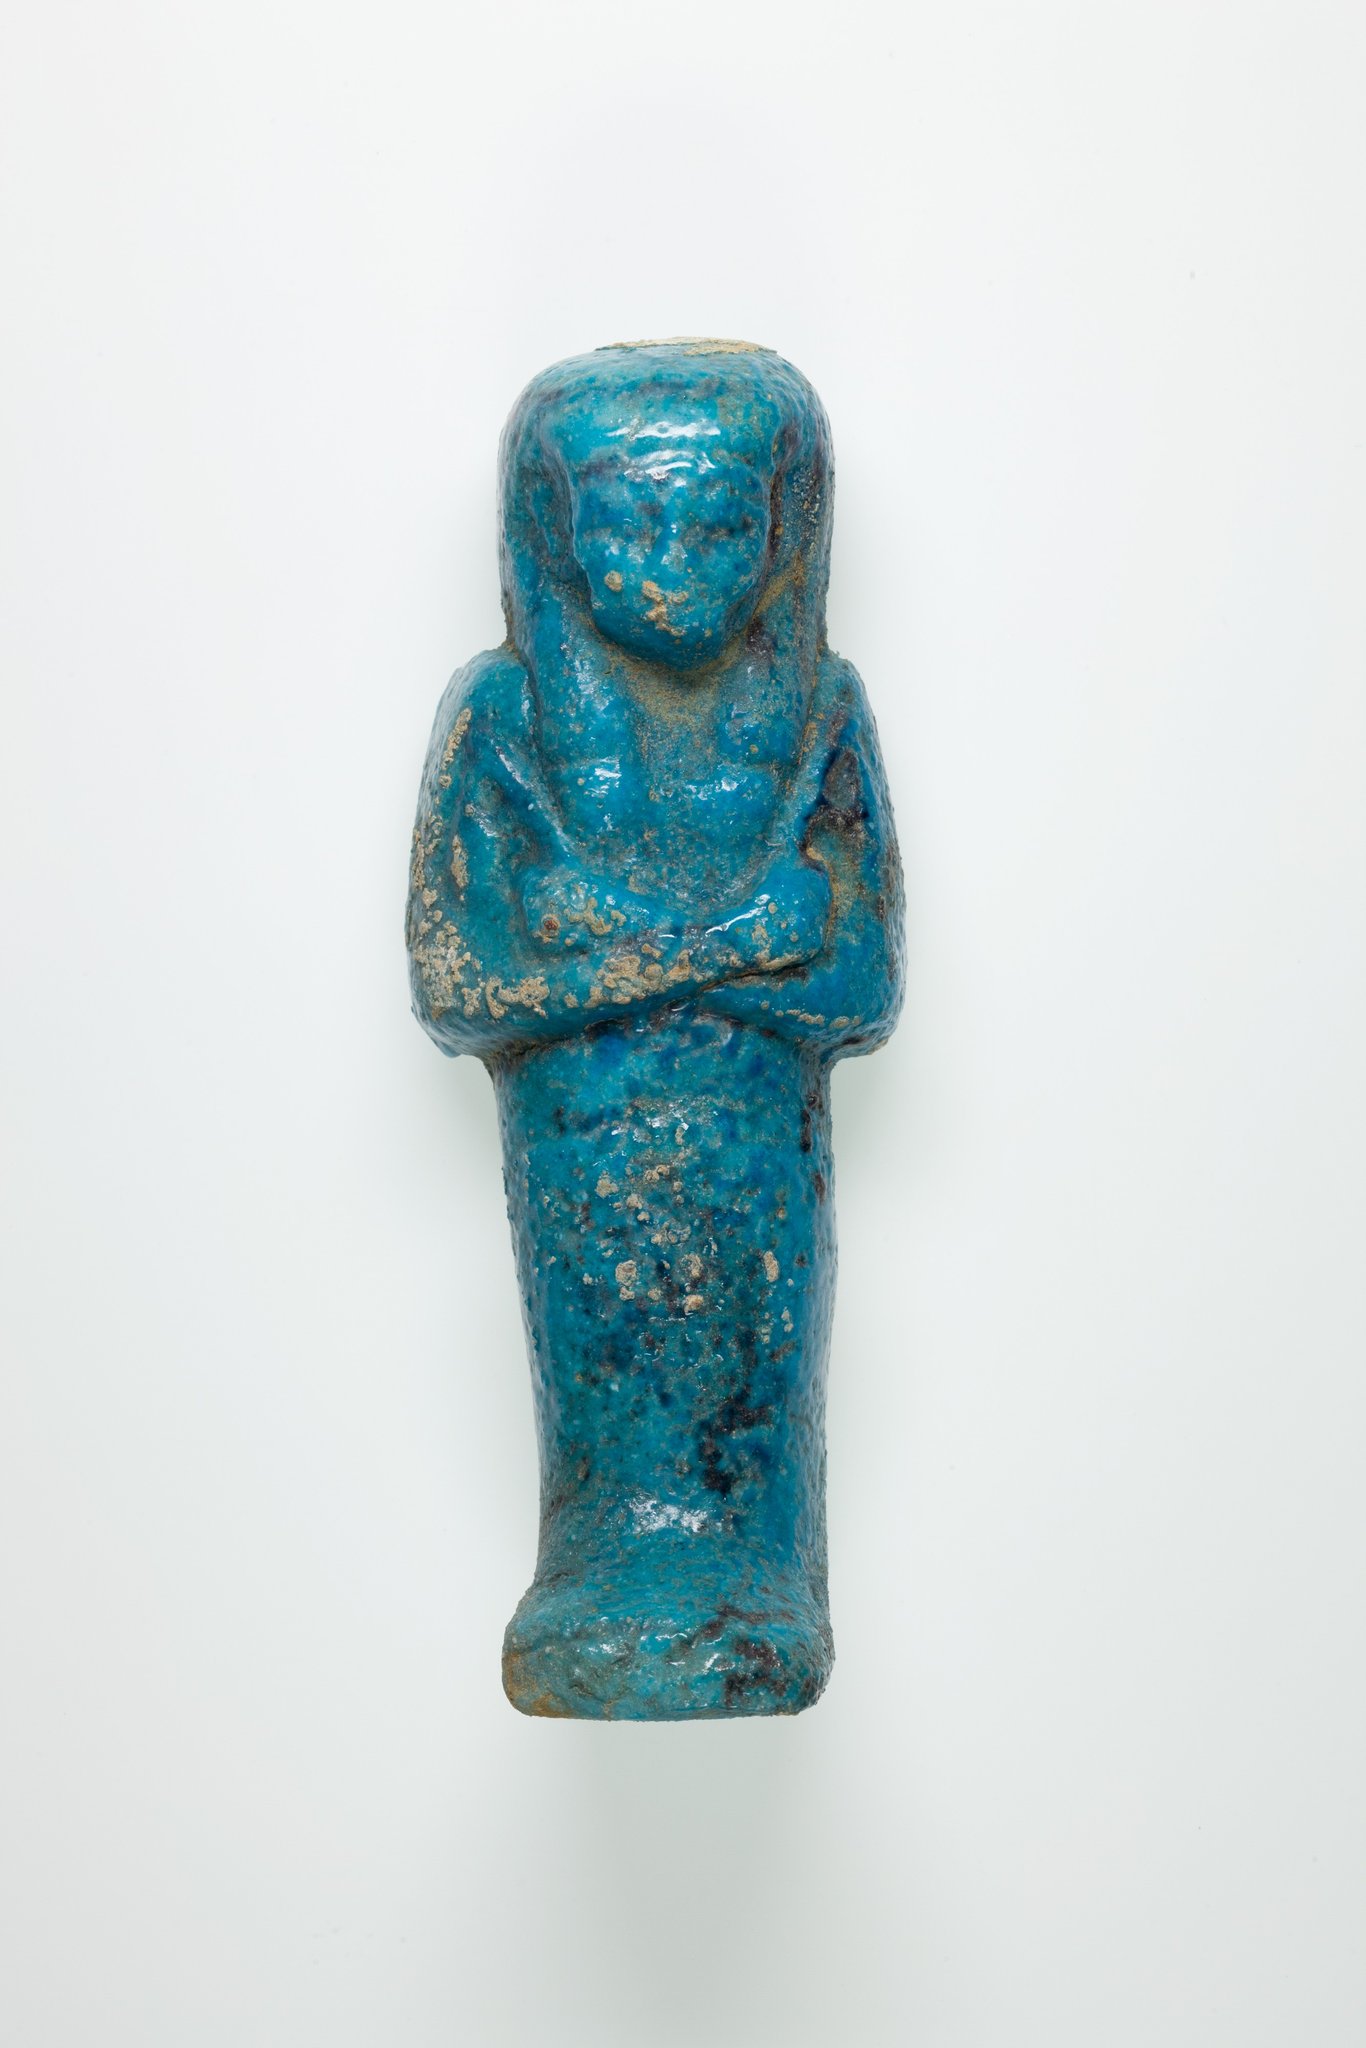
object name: worker shabti, henettawy c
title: Worker Shabti of Henettawy (C), Daughter of Isetemkheb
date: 990-970 BCE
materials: faience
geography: egypt